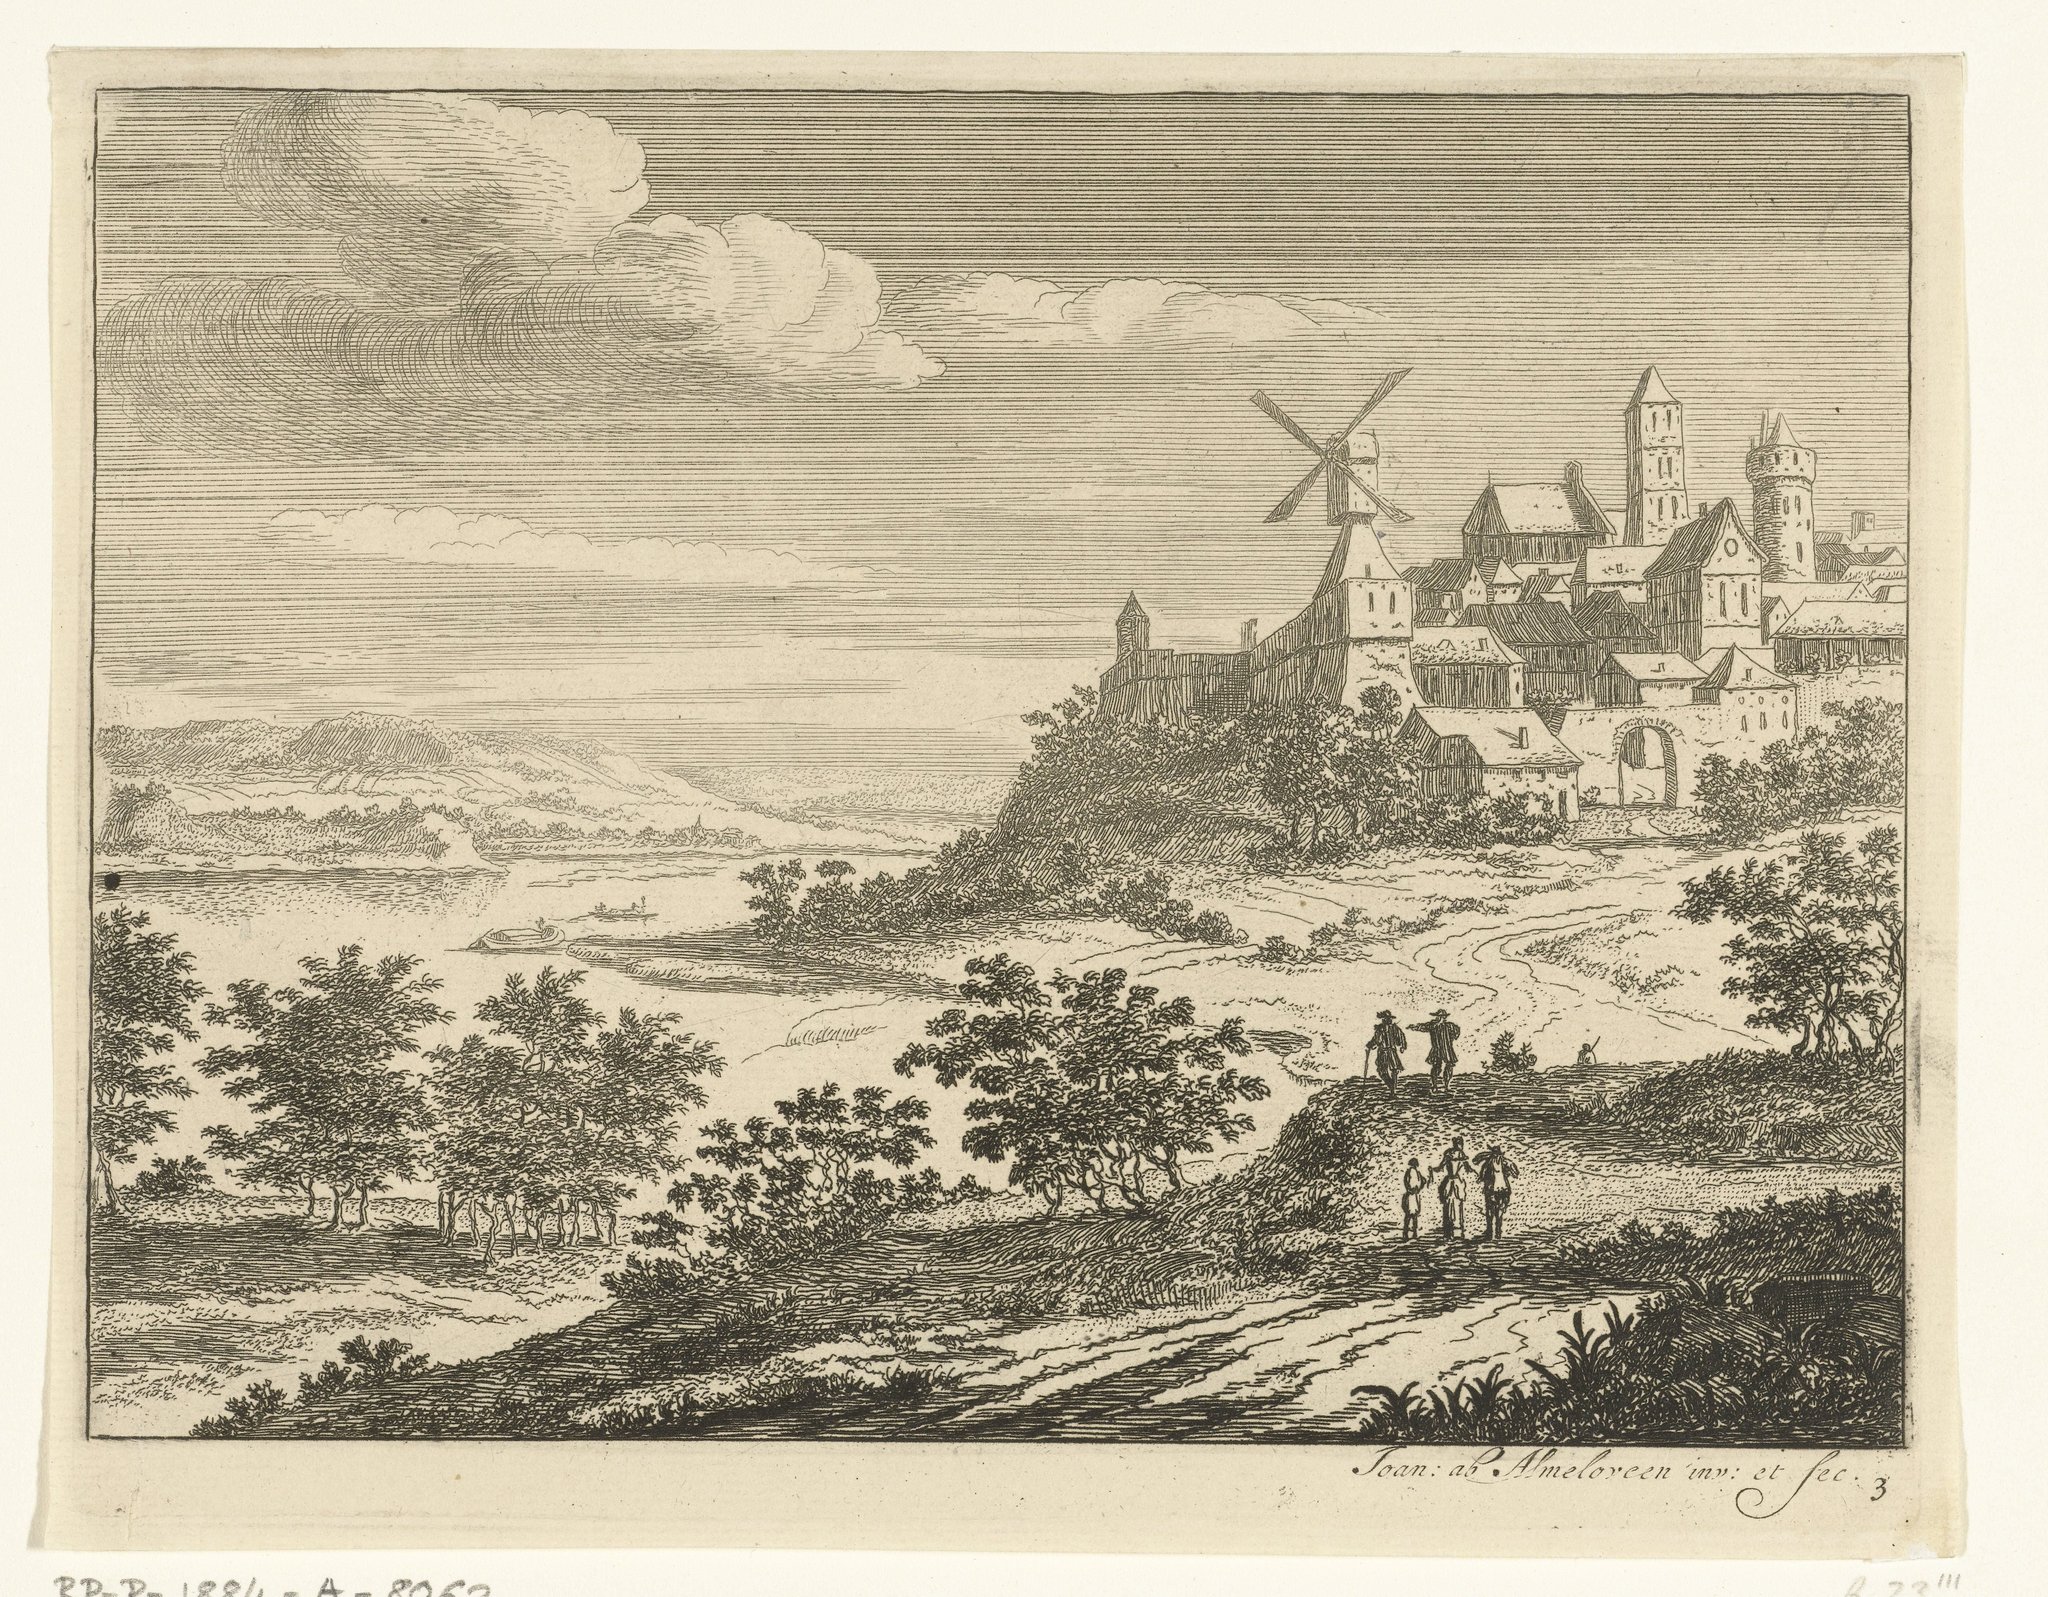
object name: print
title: Rivierlandschap met stadsgezicht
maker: jan van almeloveen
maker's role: draughtsman, print maker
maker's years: 1652-1683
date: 1662-1683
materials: paper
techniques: etching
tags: city-view in general; 'veduta'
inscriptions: collector's mark: Lugt 2228